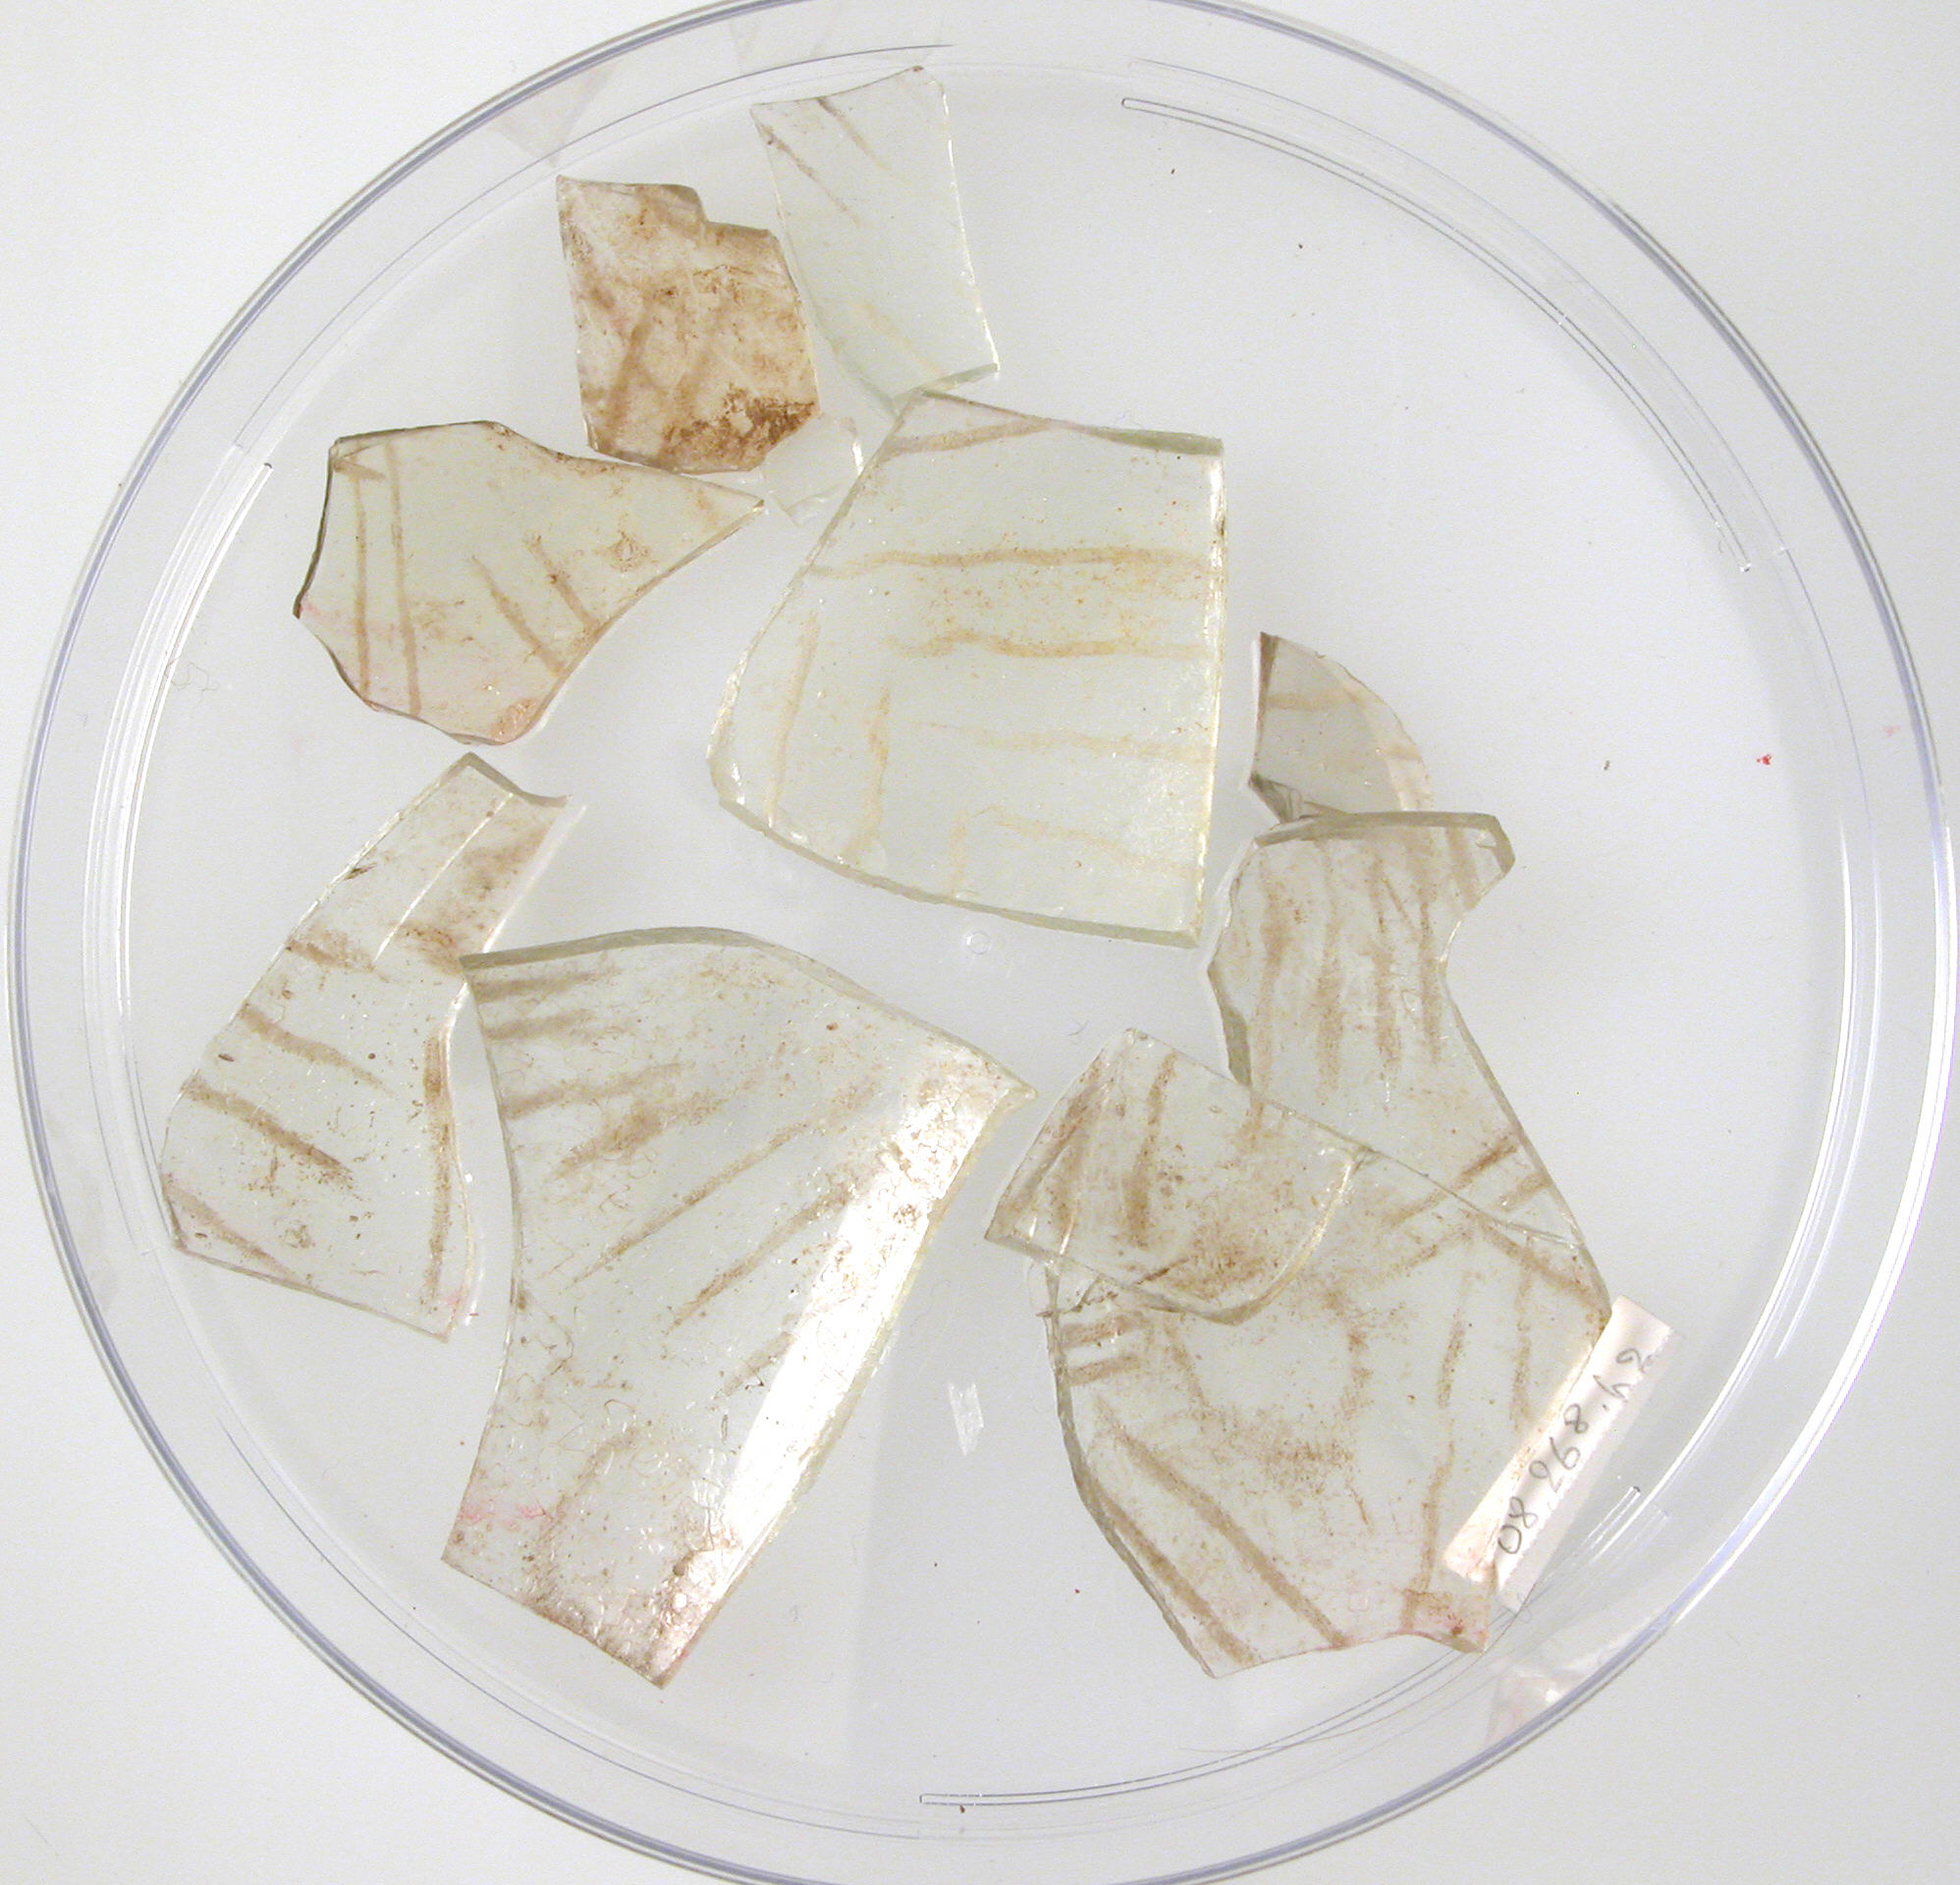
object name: fragment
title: Glass Fragments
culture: coptic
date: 301-433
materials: glass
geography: egypt